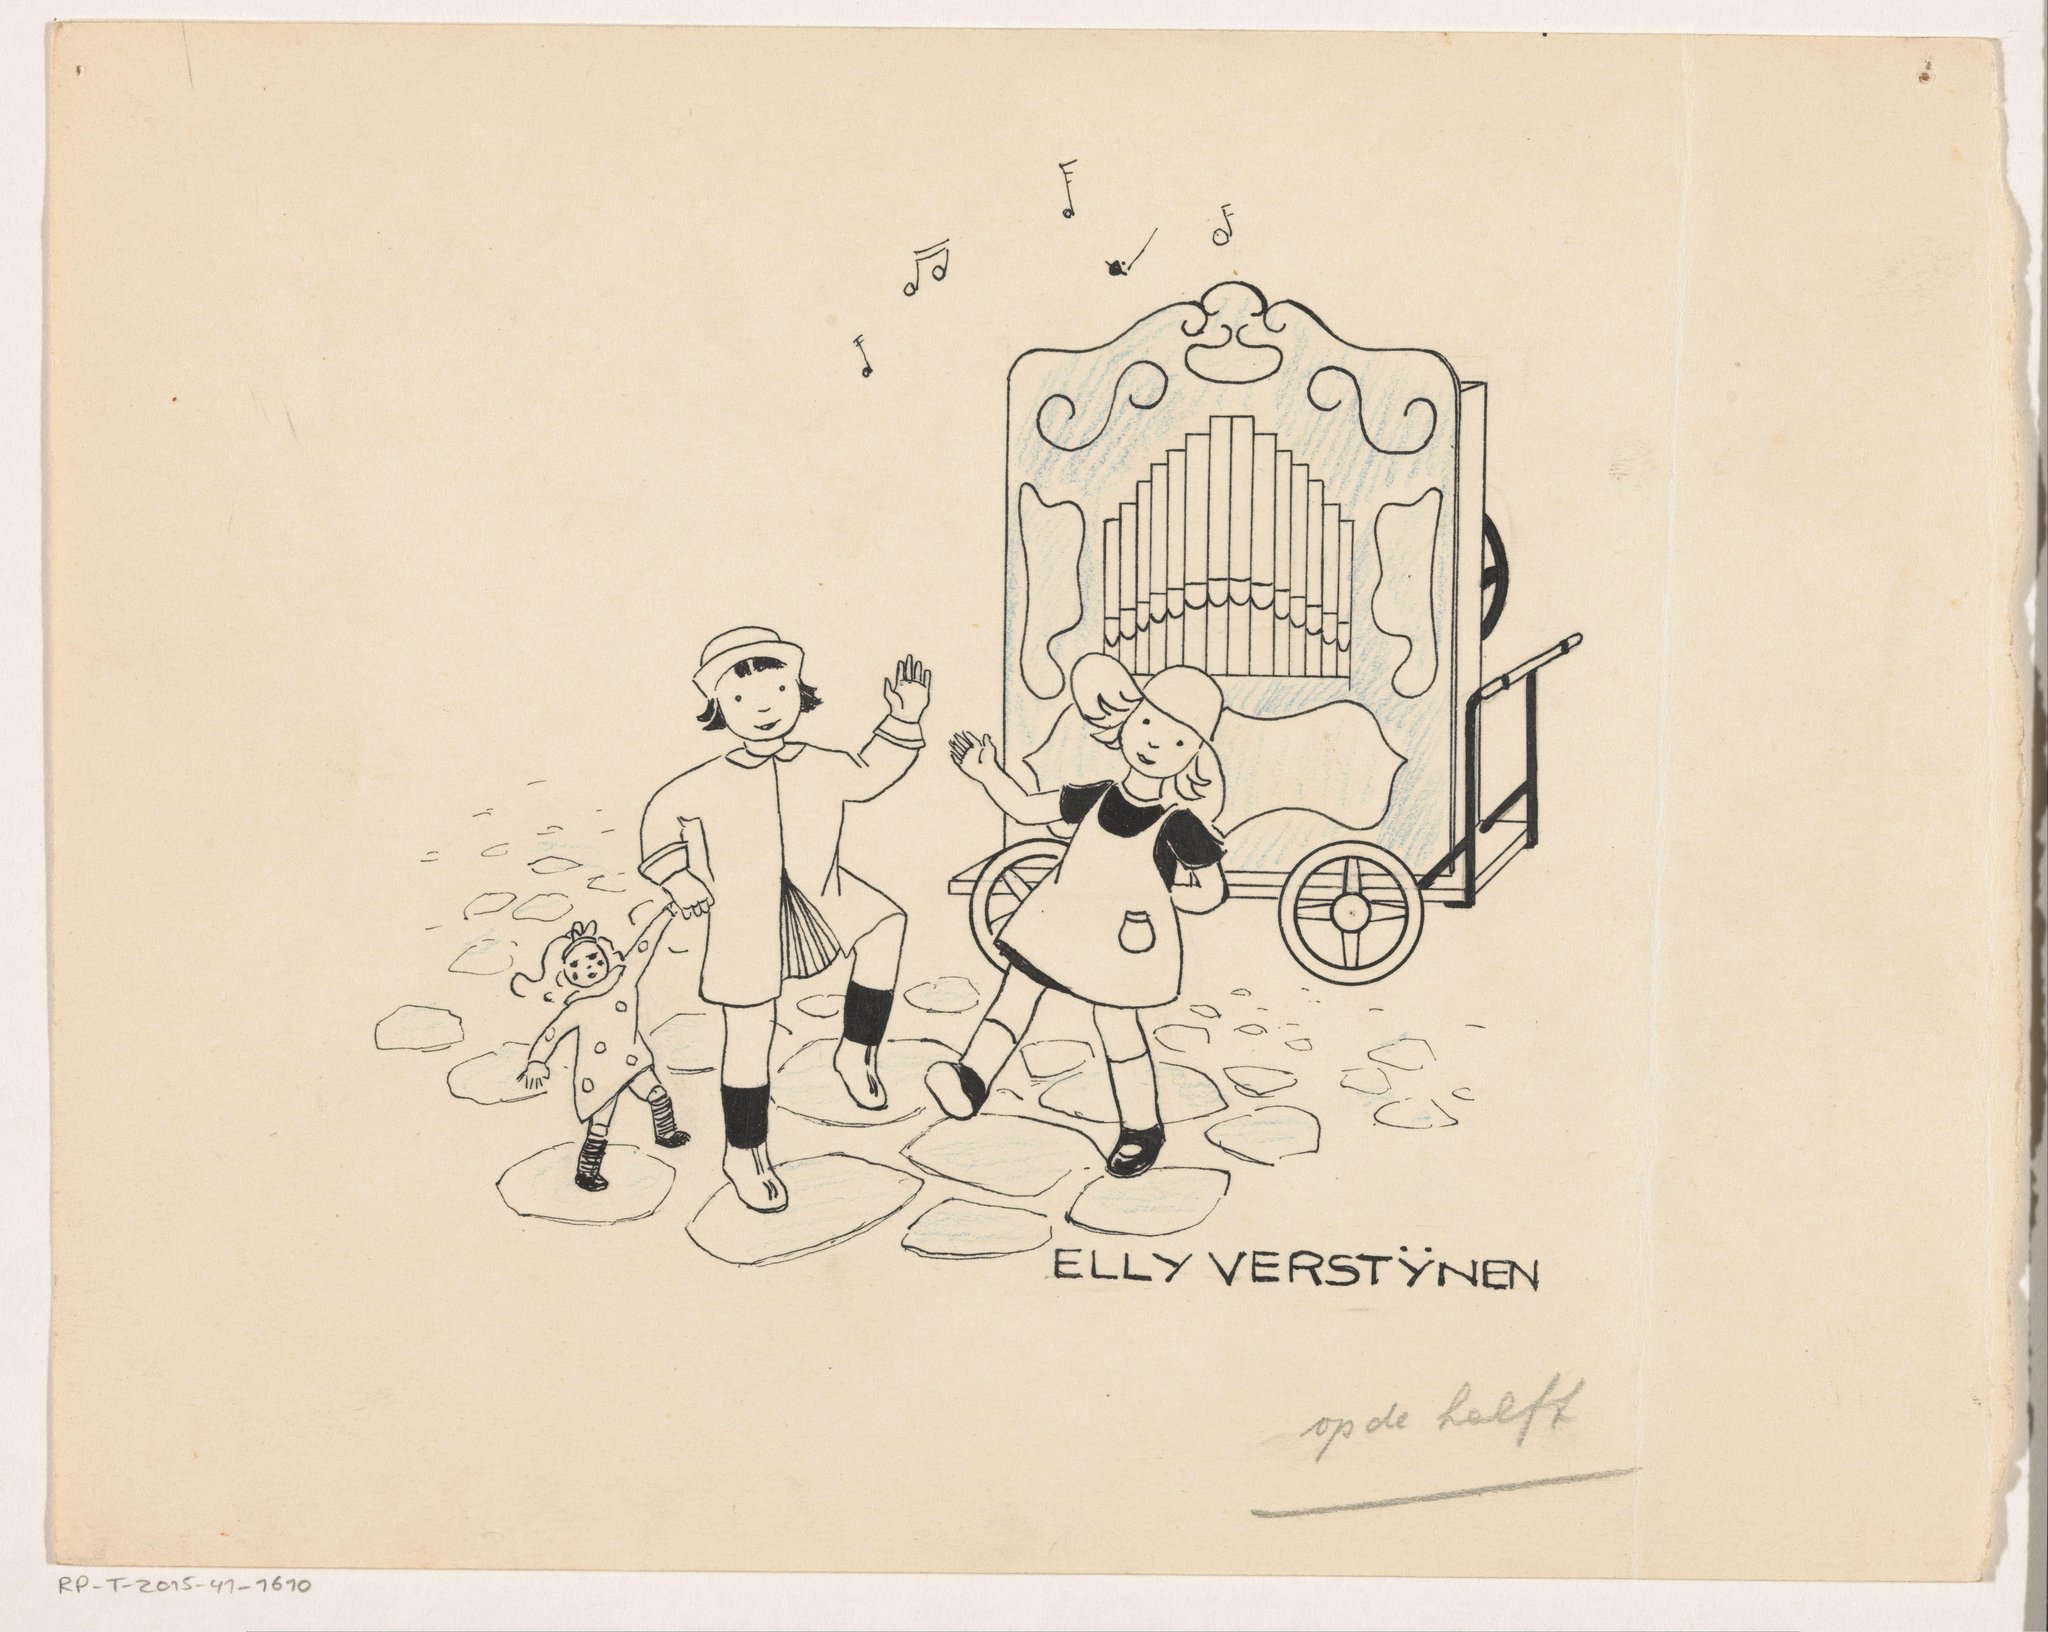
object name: boekillustratie ontwerp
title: Dansende meisjes bij een draaiorgel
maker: elly verstijnen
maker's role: draughtsman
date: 1900-1930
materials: ink, paper, pencil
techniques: pen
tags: dancing, barrel-organ player - cc - out of doors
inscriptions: collector's mark: Lugt 2228, signature: ‘ELLY VERSTYNEN’